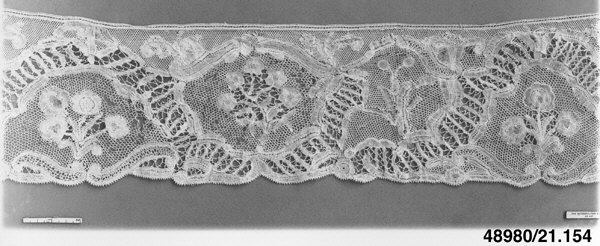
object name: flounce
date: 1701-1800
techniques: lace